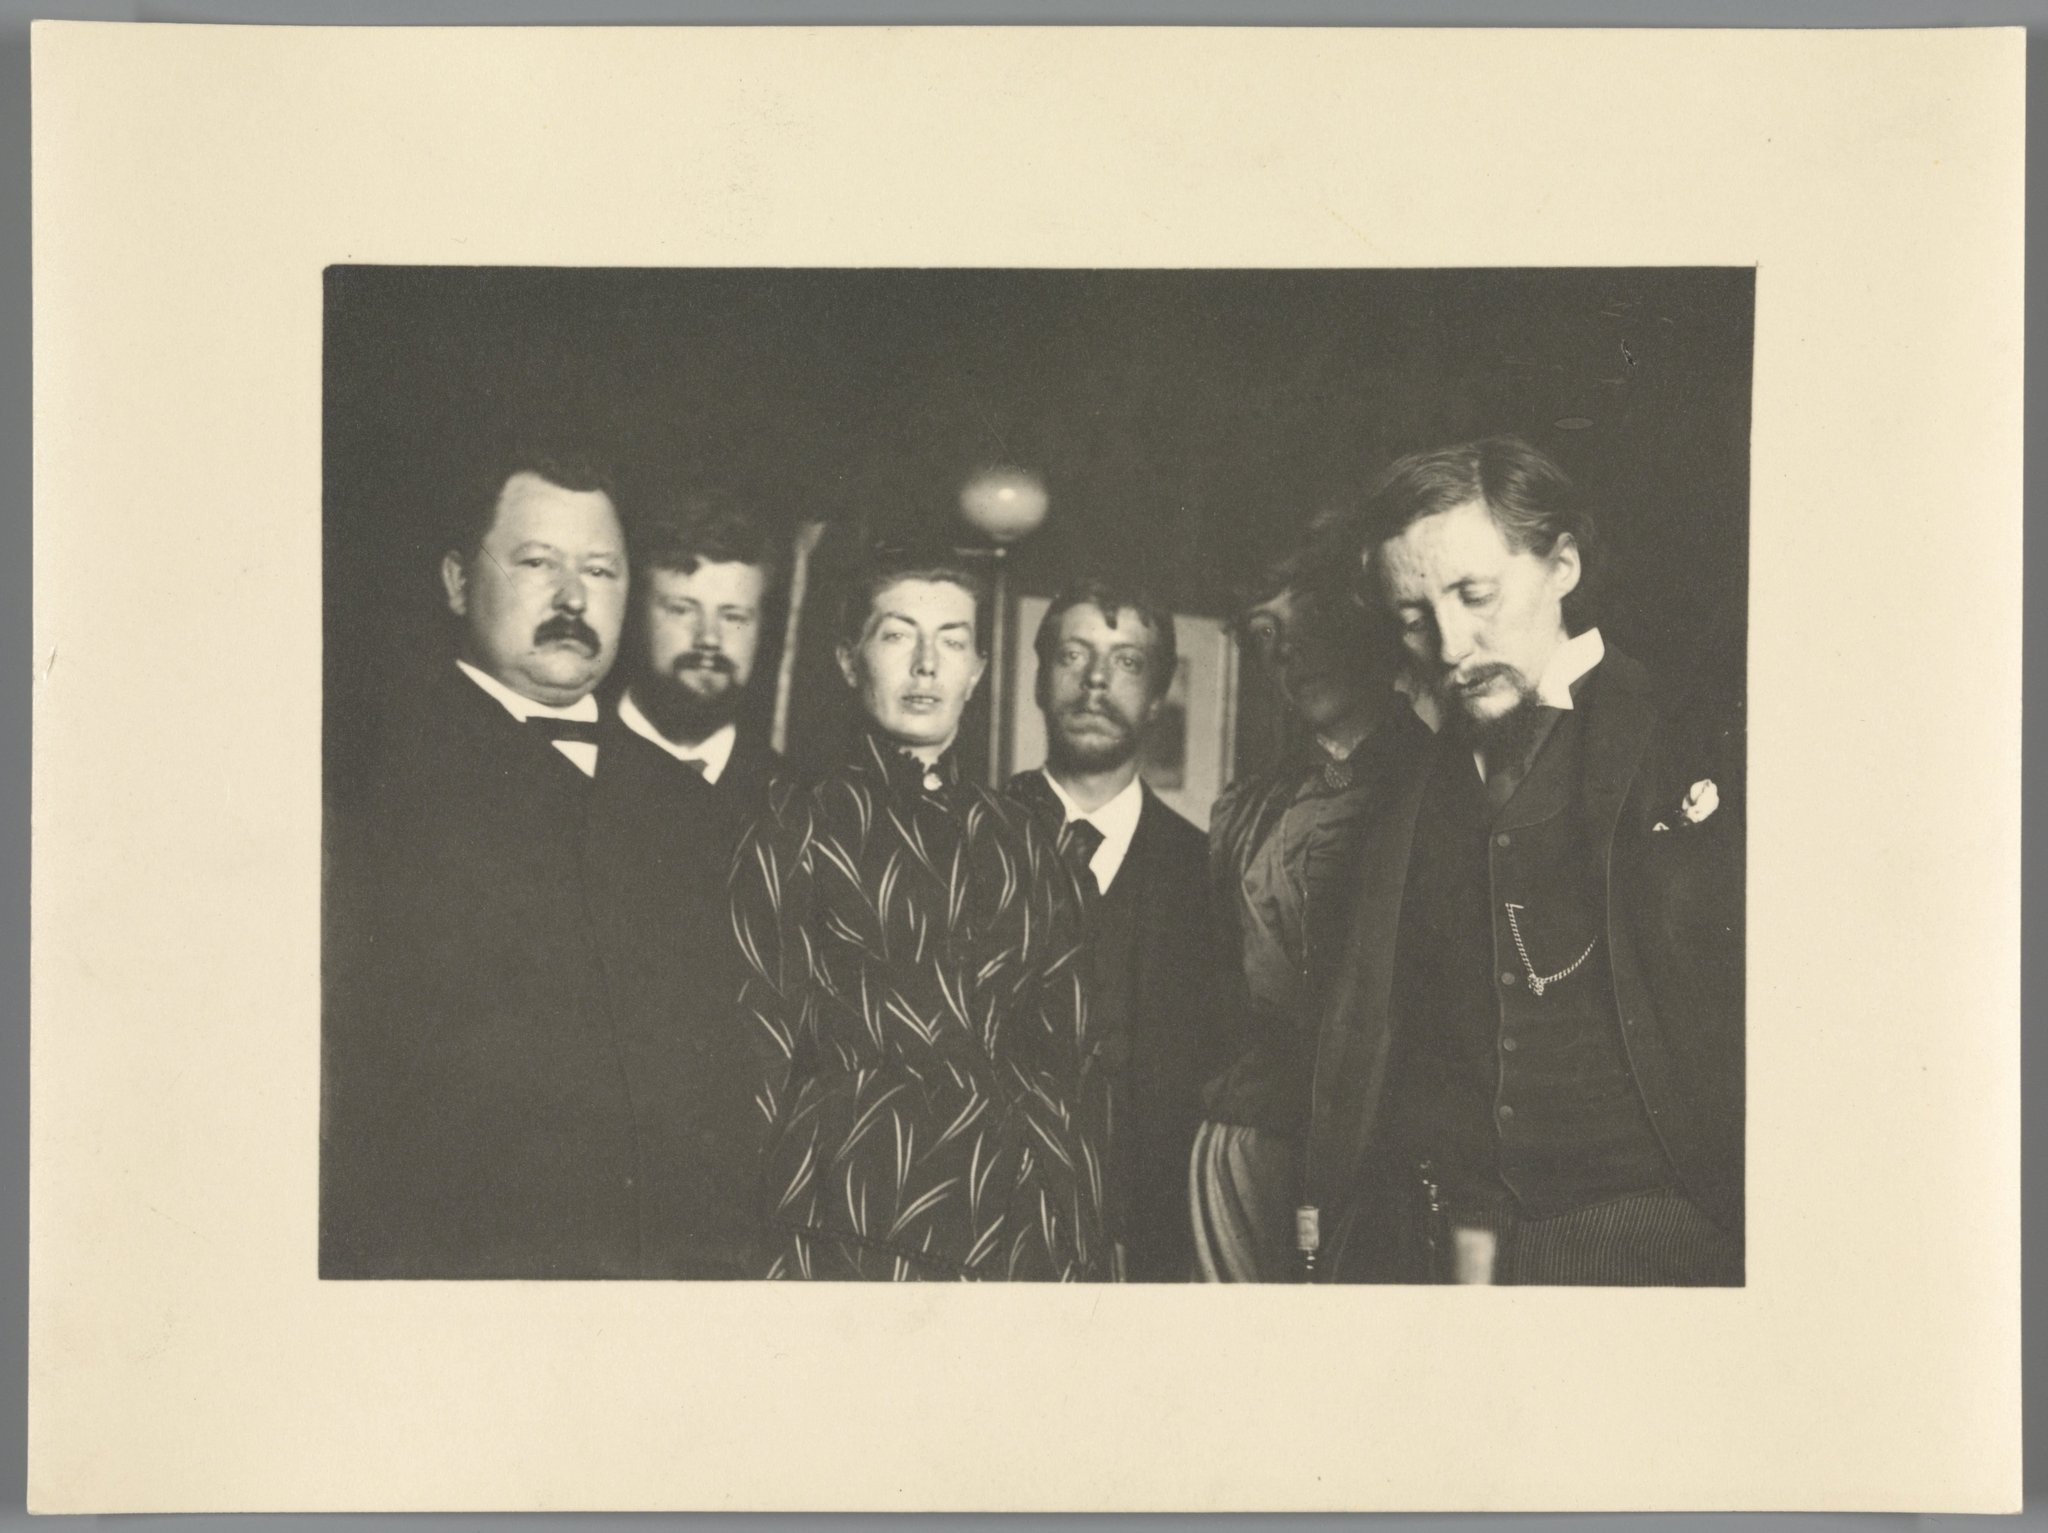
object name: photograph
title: Reproductie naar een foto van Willem Witsen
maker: Anonymous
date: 1860-1915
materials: paper, photographic support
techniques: gelatin silver print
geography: netherlands